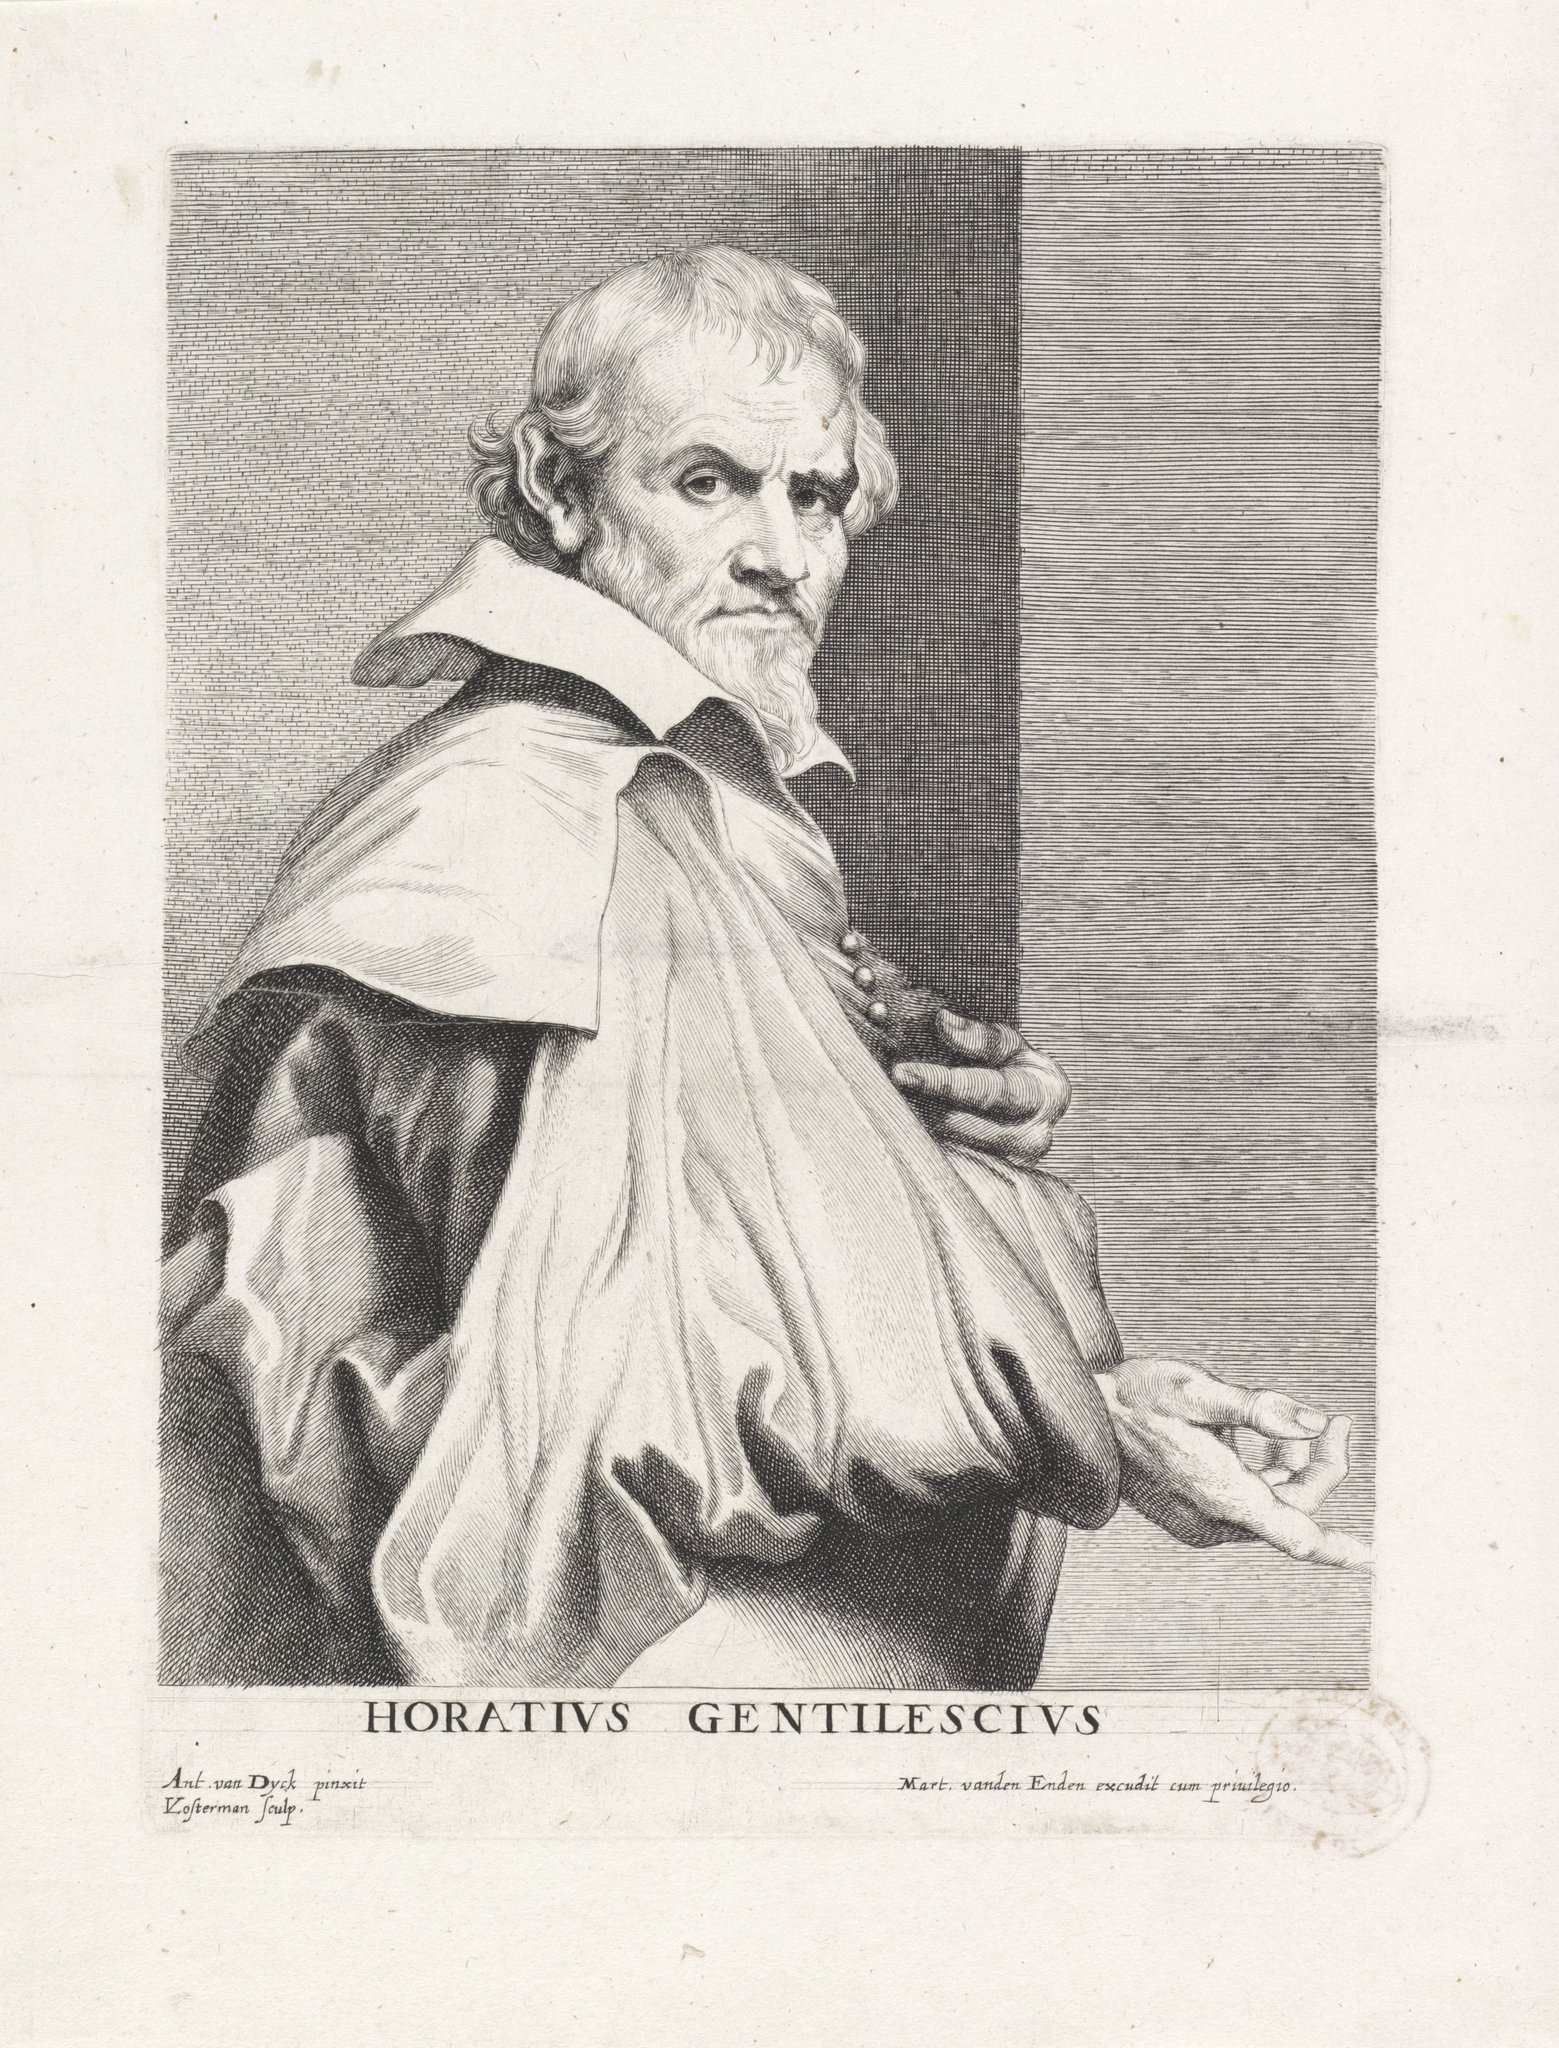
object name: print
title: Iconographie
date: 1630-1646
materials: paper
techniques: engraving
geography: antwerp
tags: orazio gentileschi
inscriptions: collector's mark: Lugt 240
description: Prent gebruikt voor: Icones principum, virorum doctorum, pictorum, chalcographorum, statuariorum nec non amatorum pictoriae artis numero centum ab Ant. van Dyck ad vivum expressae ejusque sumptibus aeri incisae. Antwerpen: Gillis Hendricx, [1645-1646].